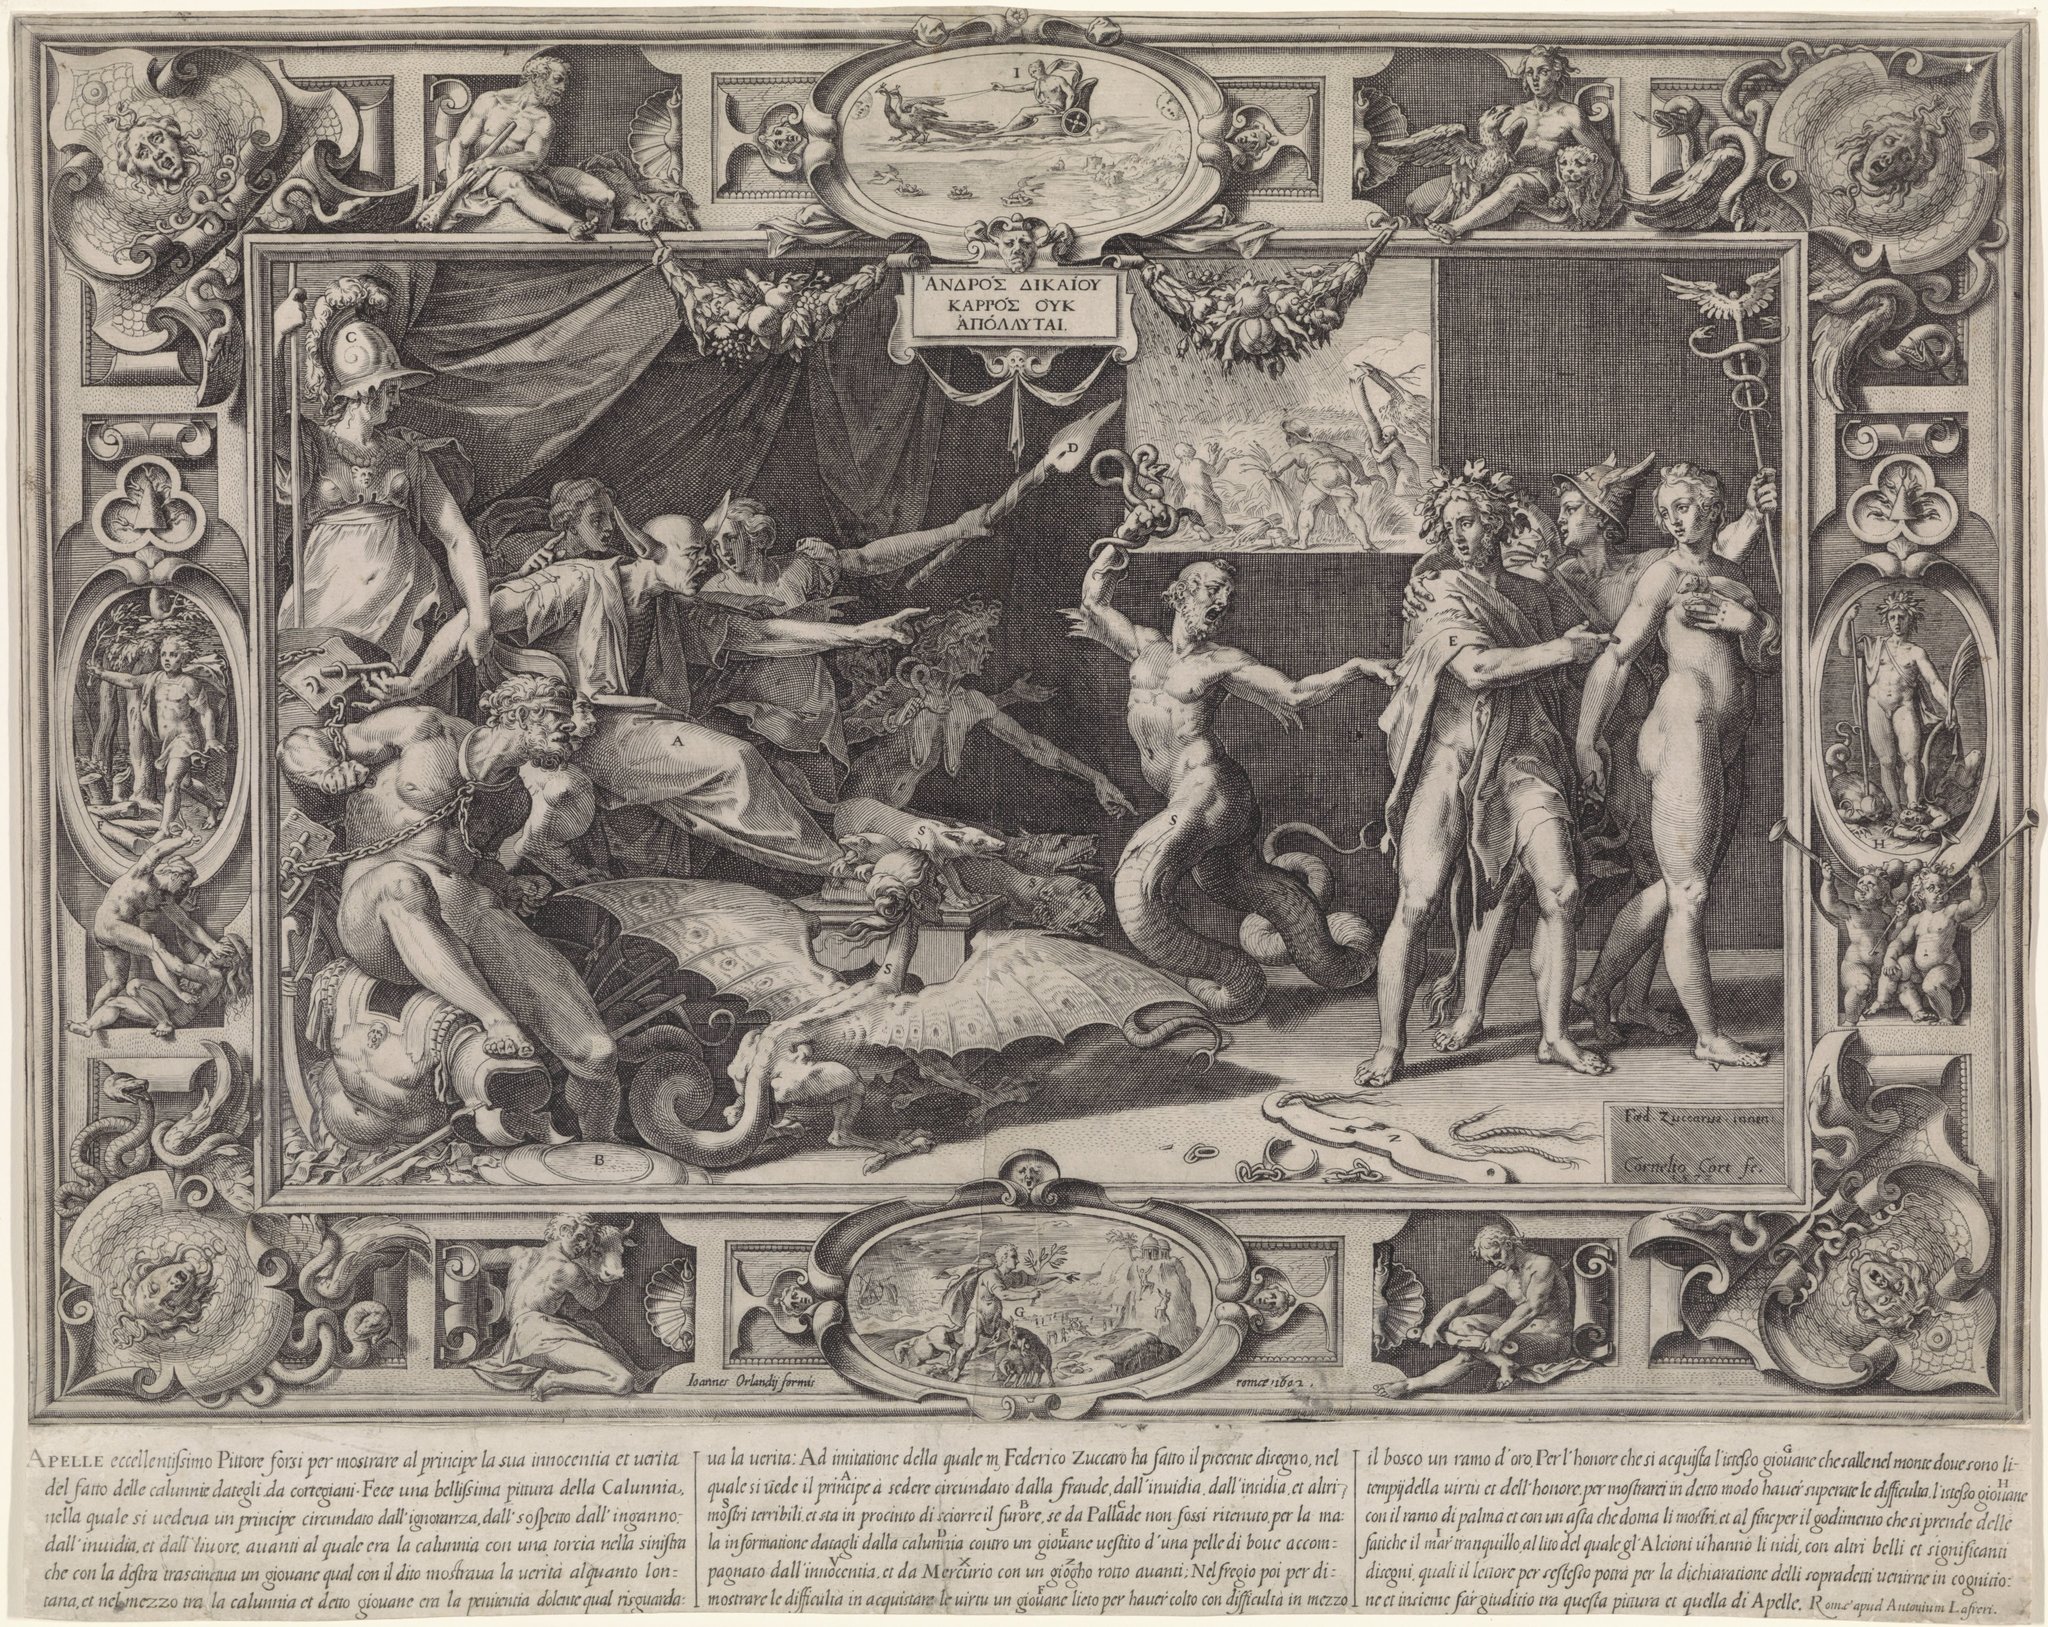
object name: print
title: Laster van Apelles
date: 1602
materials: paper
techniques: engraving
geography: rome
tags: calumny of apelles: bad judge with ass's ears on throne, with deceit, envy, ignorance, suspicion and treachery, confronted with innocent accused; remorse and truth present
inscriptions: collector's mark: Lugt 240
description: Links op een troon zit een koning wiens domheid wordt getoond door zijn ezelsoren. Zijn adviseurs zijn Laster, Bedrog, Afgunst en Woede. Achter de troon staat Minerva om hem tegen te houden. Rechts een kunstenaar die onder valse voorwendsels door de koning veroordeeld zou worden. Hij wordt vergezeld door de naakte Waarheid en de god Mercurius.